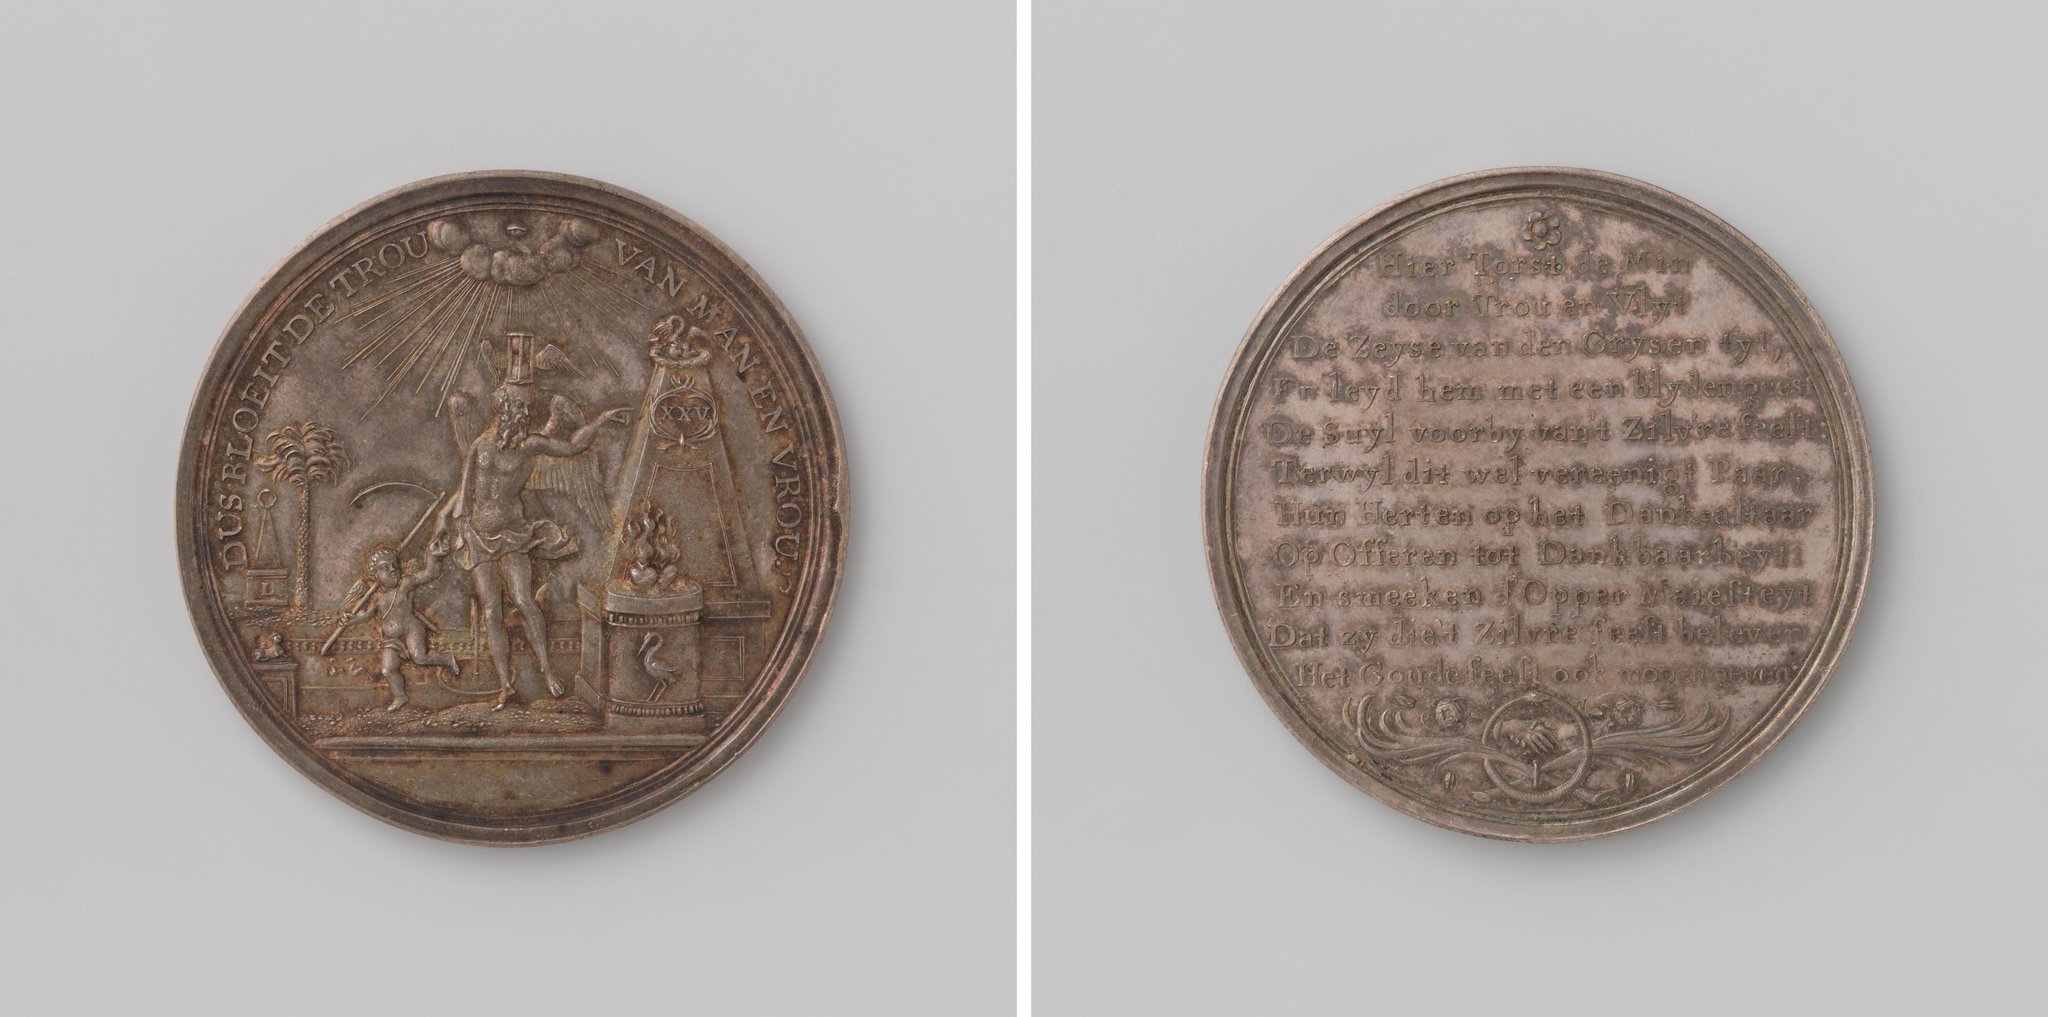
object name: huwelijksjubileumpenning 25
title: Vijfentwintigjarige huwelijk van J.C. Cuyck van Mierop en Sara Cloek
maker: martinus holtzhey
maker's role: medailleur, muntmaker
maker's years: 1697-1764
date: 1764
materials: silver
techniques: engraving, striking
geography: amsterdam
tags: j.c. cuyck van mierop, sara cloek